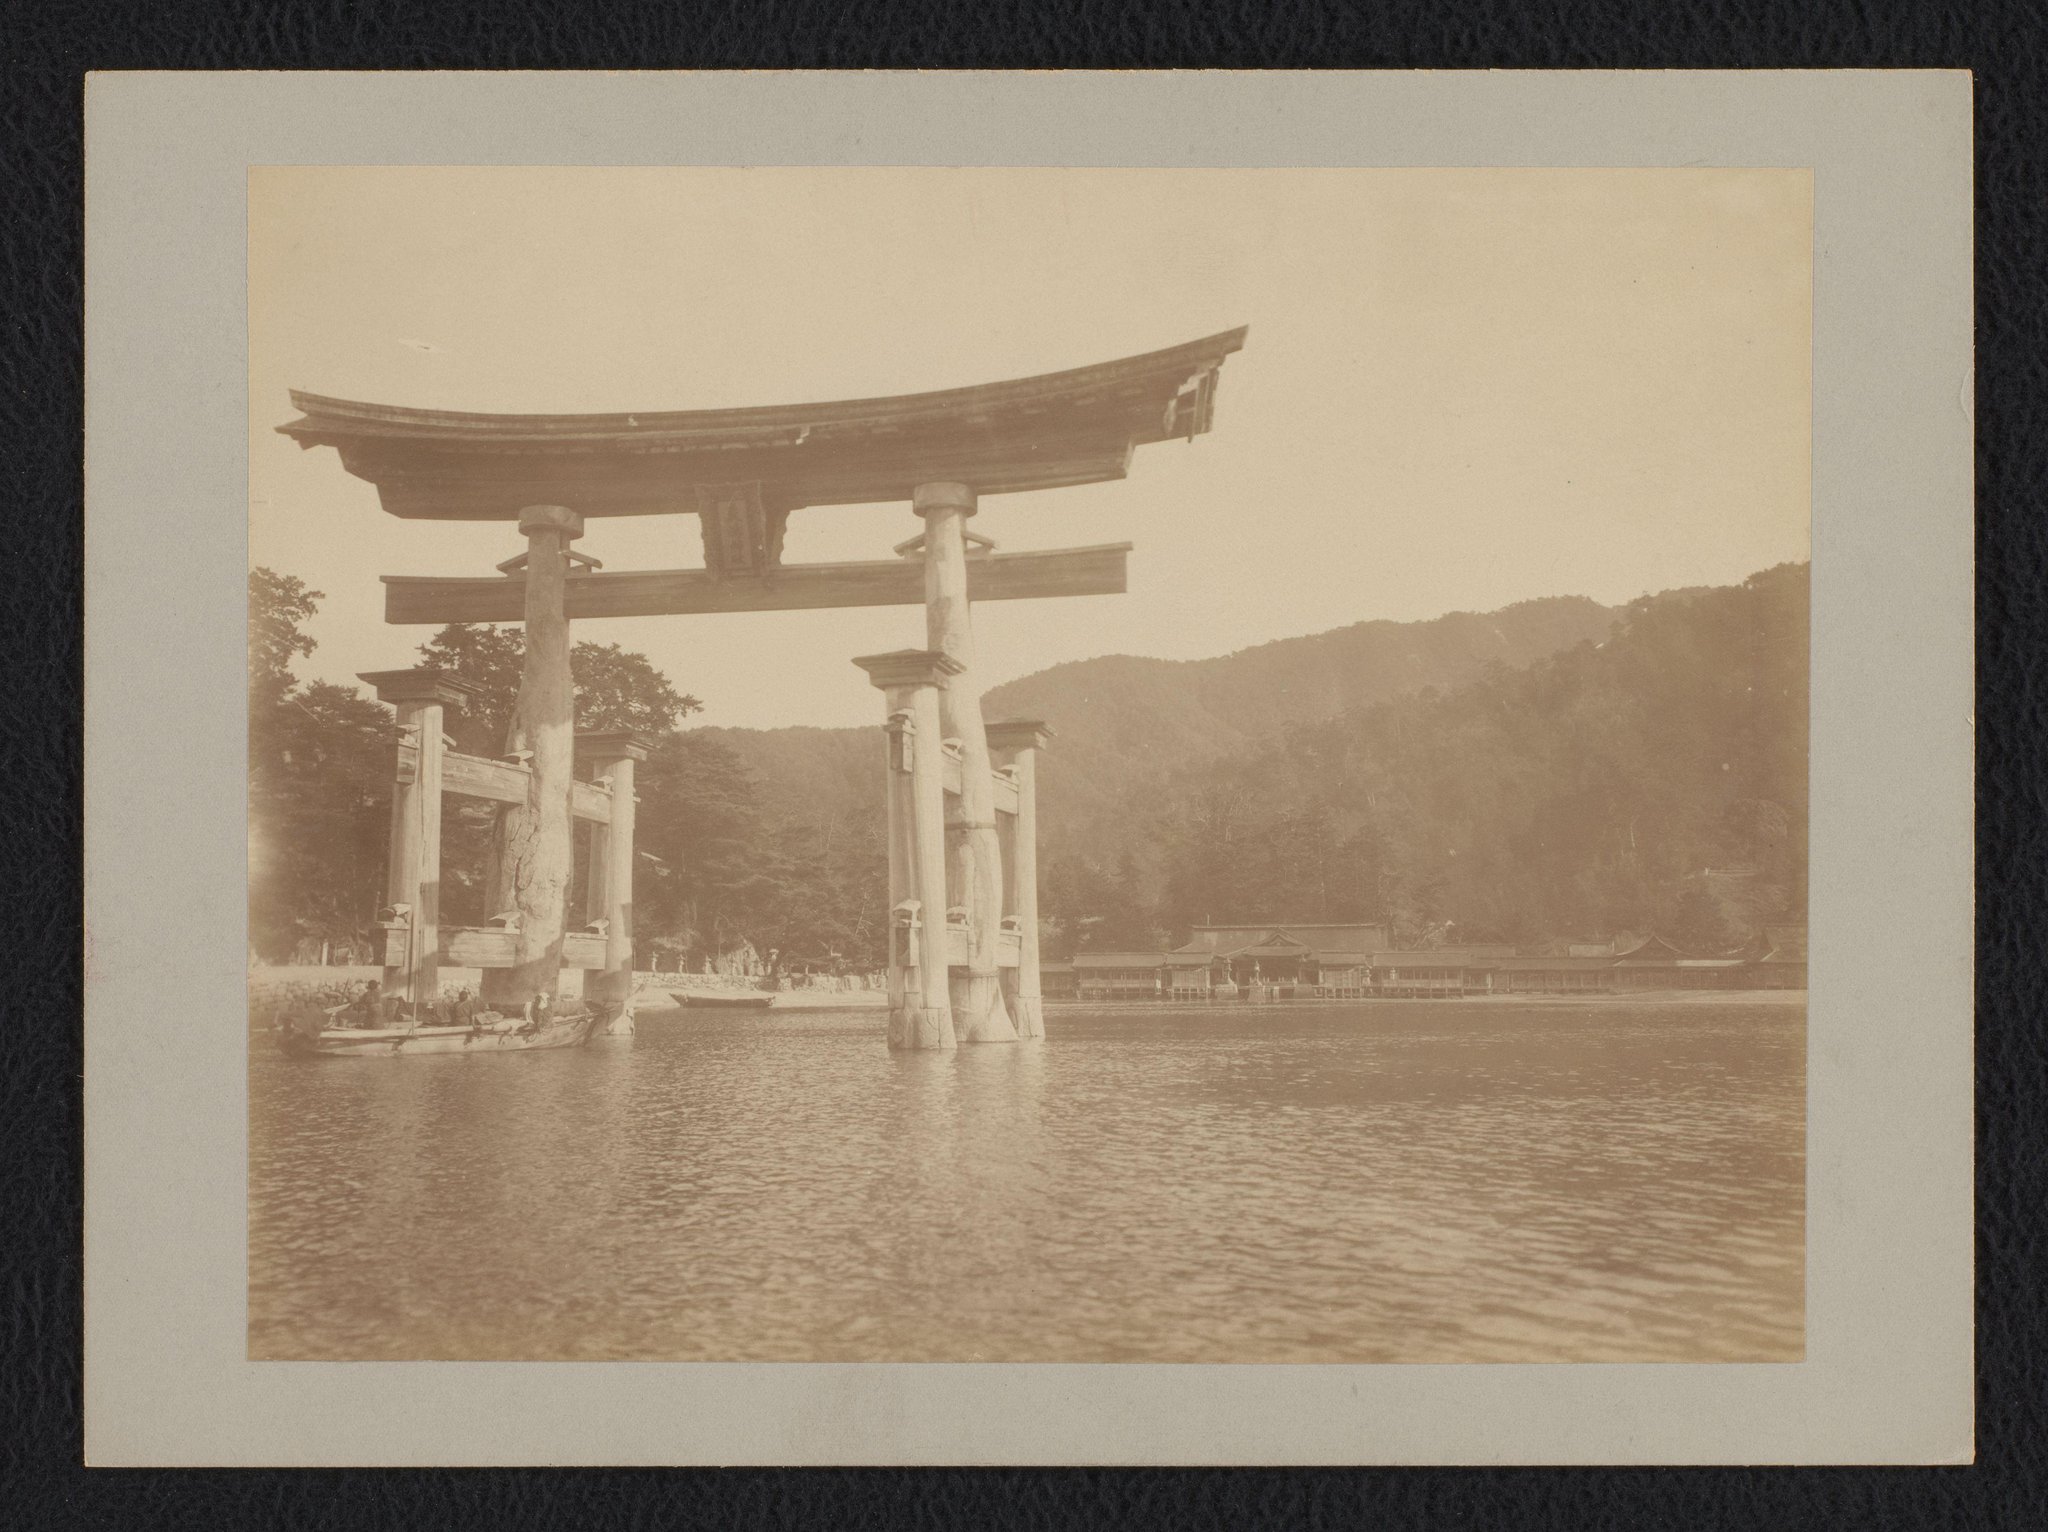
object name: photograph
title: Torri in zee voor het heilige eiland Miyajima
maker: Anonymous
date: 1895-1915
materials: cardboard, photographic support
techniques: albumen print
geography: miyajima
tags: miyajima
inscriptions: annotation: ‘1) Heilige eiland Miyajima’